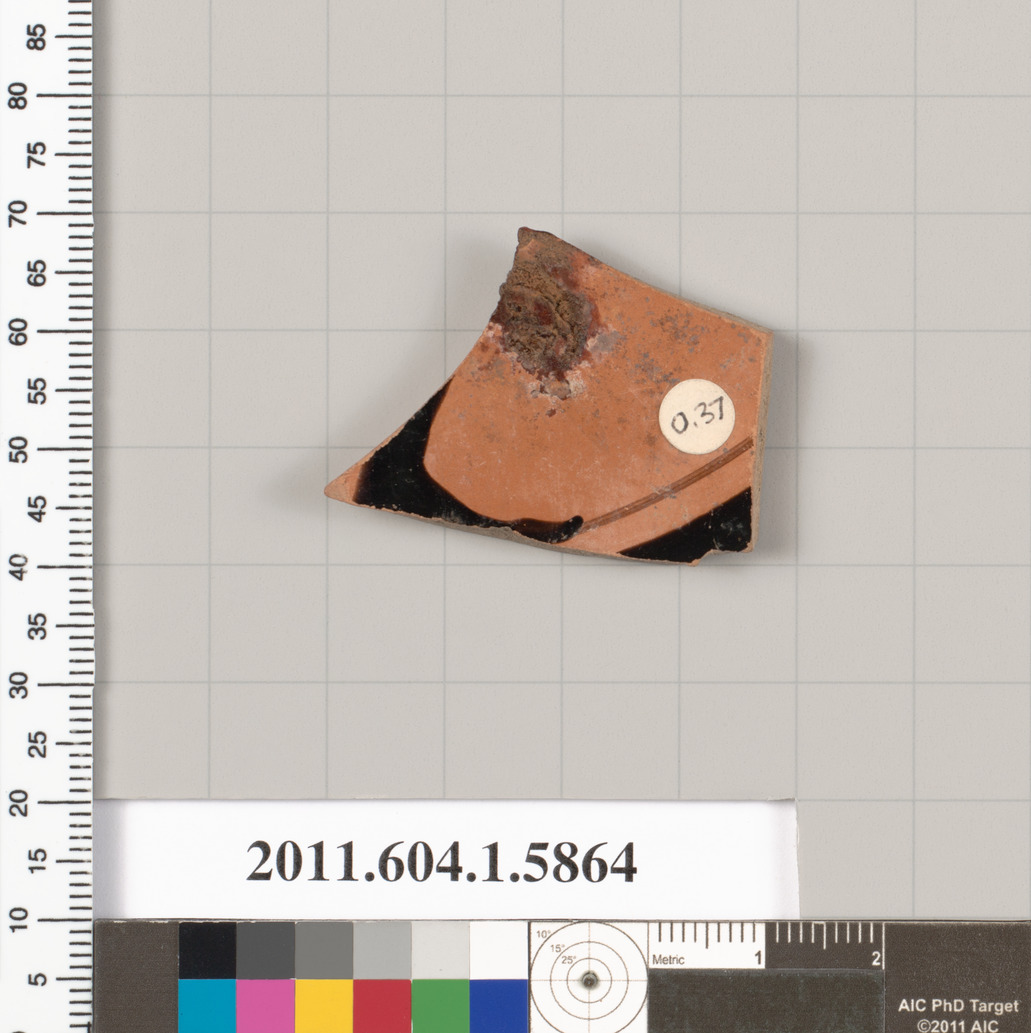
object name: kylix fragment, eye cup, bilingual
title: Terracotta fragment of a kylix (drinking cup)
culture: greek, attic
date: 433-567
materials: terracotta